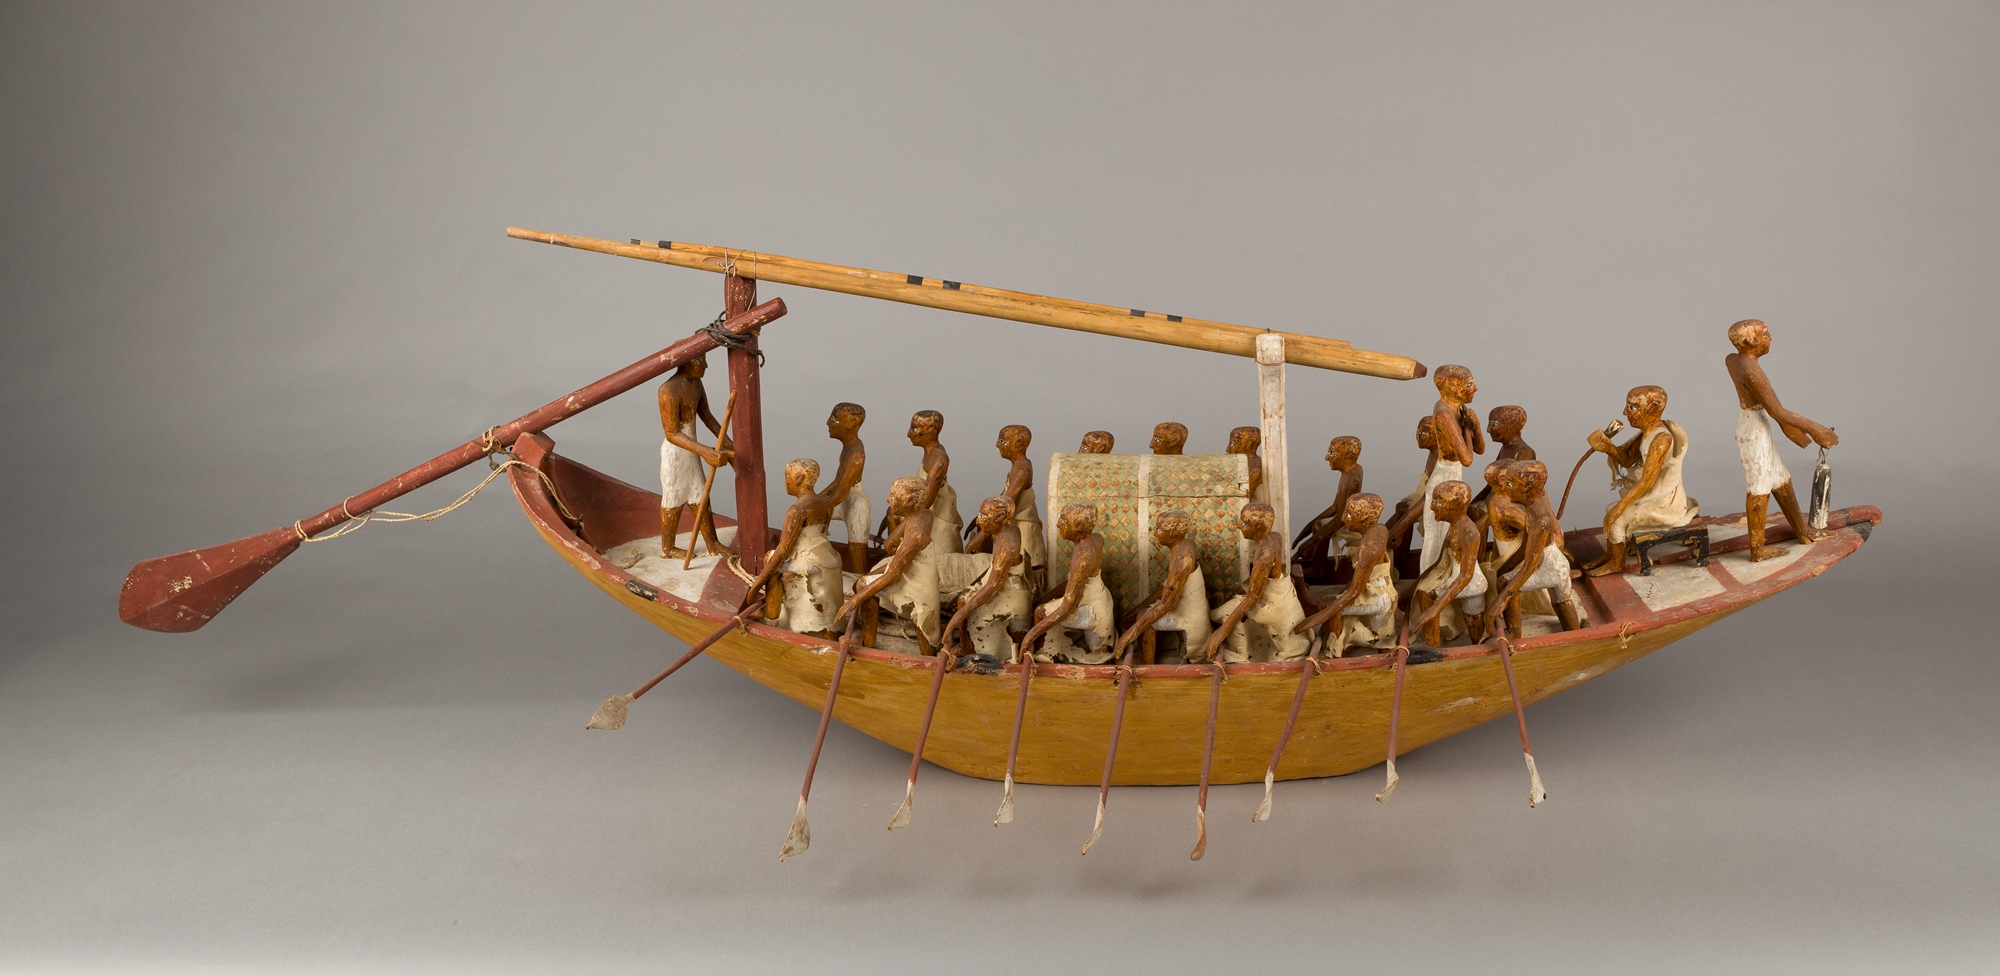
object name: boat, traveling, meketre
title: Travelling Boat being Rowed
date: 1981-1975 BCE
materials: textile, linen, paint, plaster, wood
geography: egypt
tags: men,rowing,boats,meketre-models